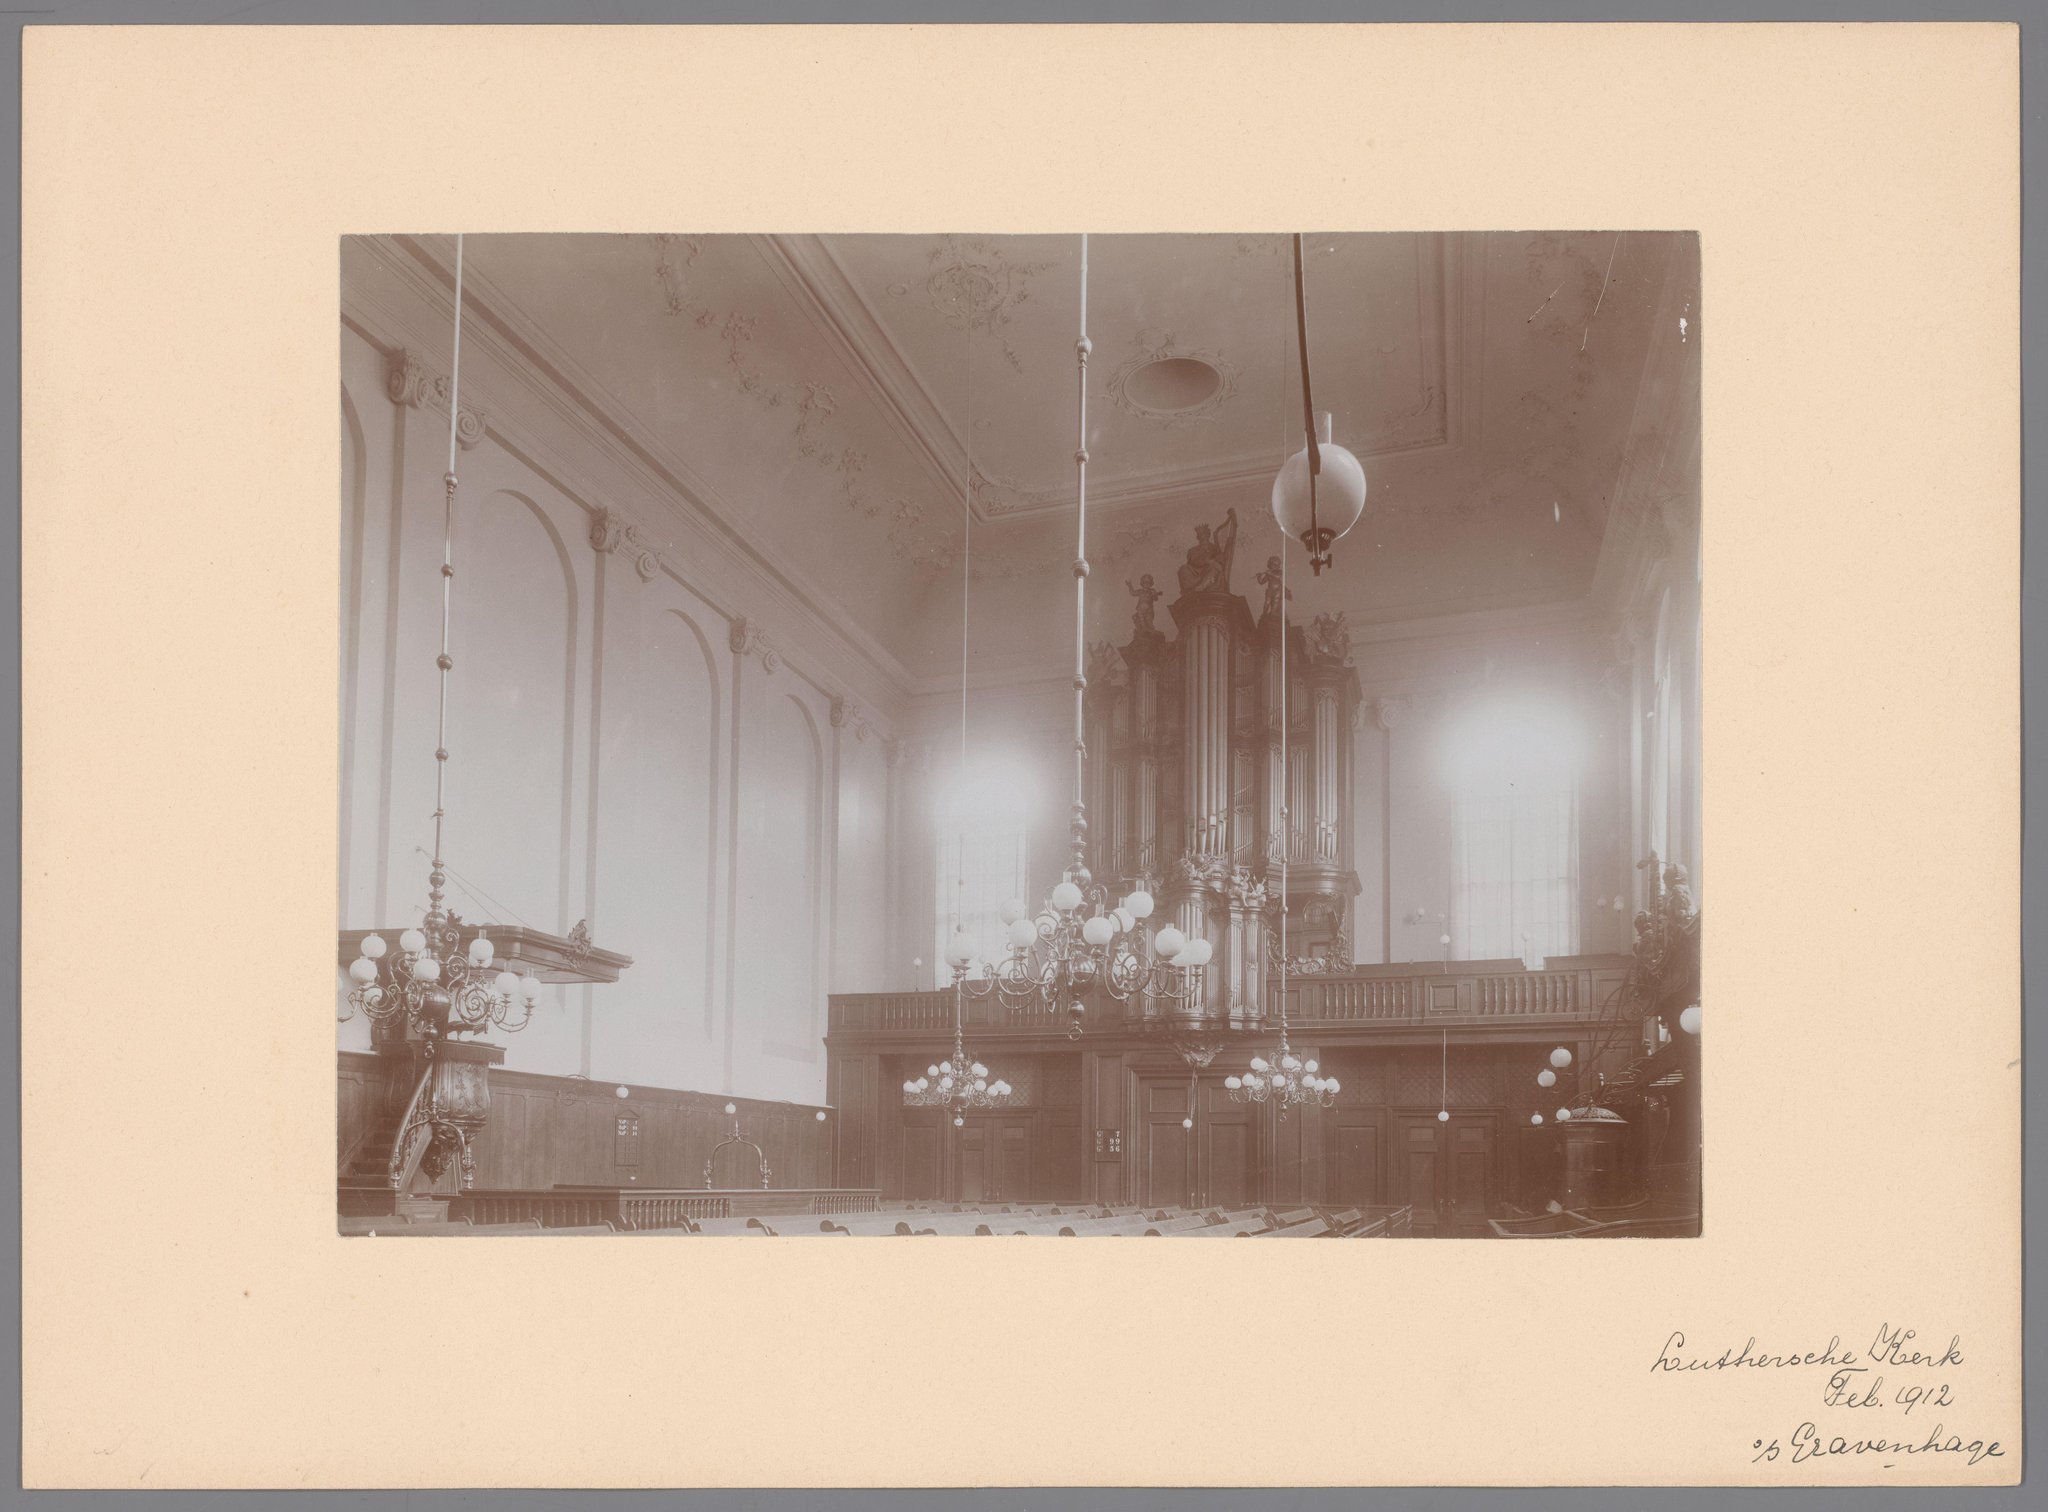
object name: photograph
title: Interieur met orgel van de Lutherse kerk te Den Haag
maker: anoniem (monumentenzorg)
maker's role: fotograaf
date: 1912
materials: cardboard, photographic support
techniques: collodion silver print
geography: the hague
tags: church organ, interior of church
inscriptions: annotation: ‘Luthersche kerk/ Feb 1912/ 's Gravenhage’, collector's mark: ‘R:MUS.’ Lugt 2228